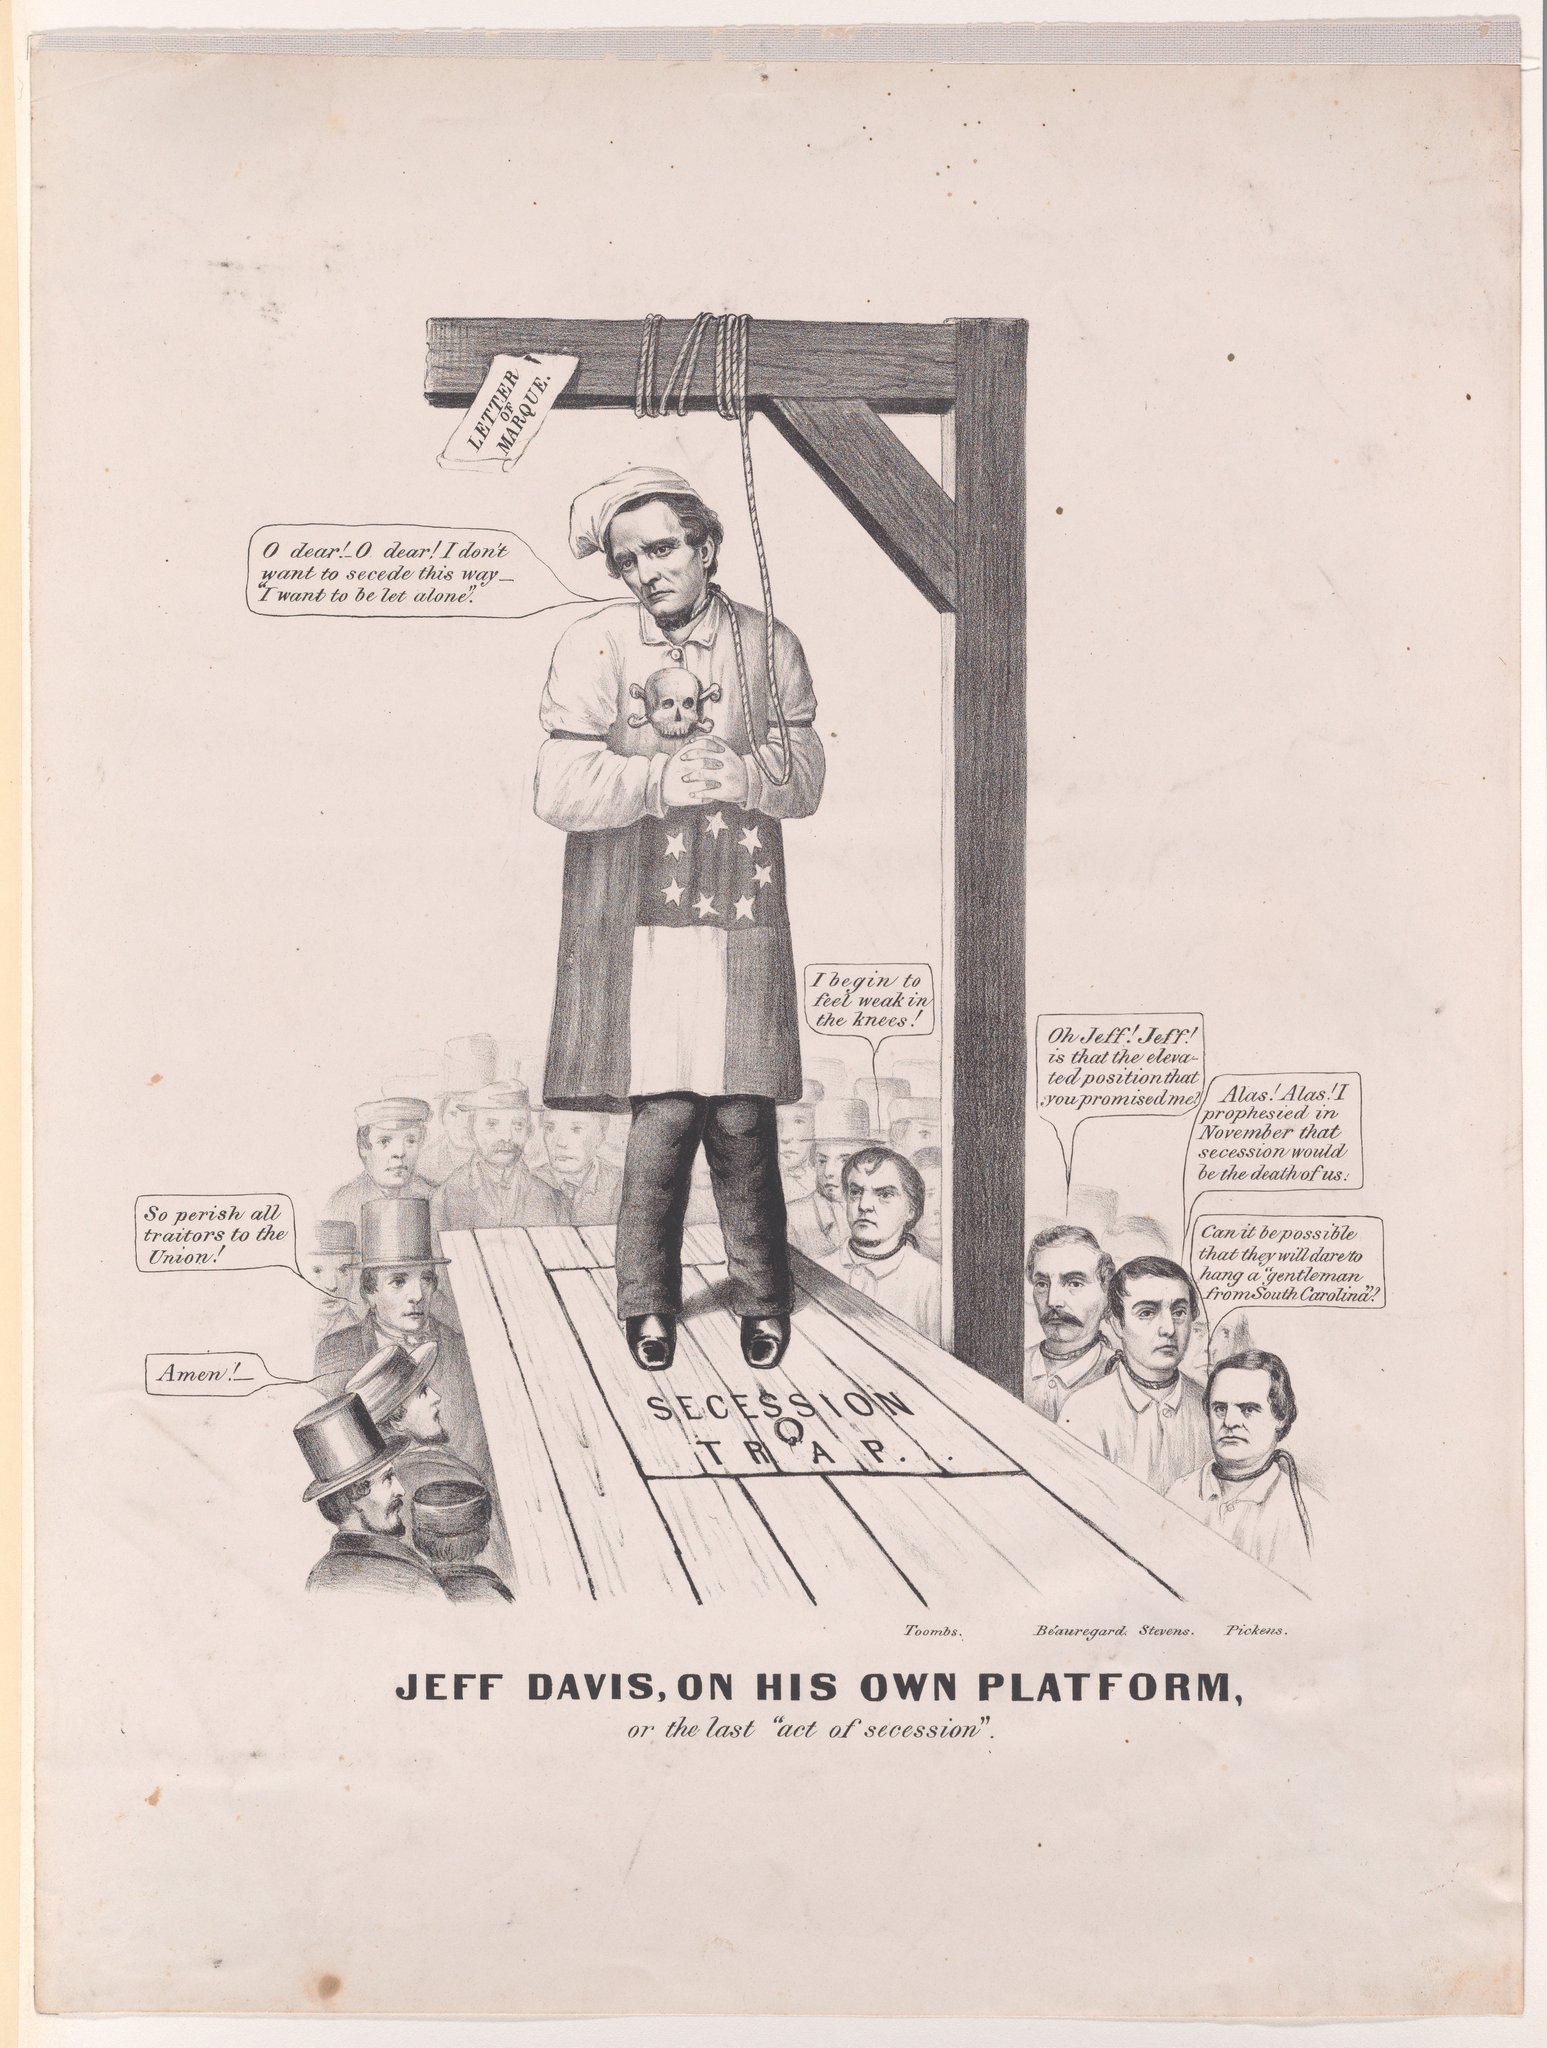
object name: print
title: Jeff Davis on His Own Platform, or the Last "Act of Secession"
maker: currier & ives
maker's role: publisher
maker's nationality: american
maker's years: 1857-1907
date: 1861-1862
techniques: lithograph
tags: satire,american civil war,men,politics